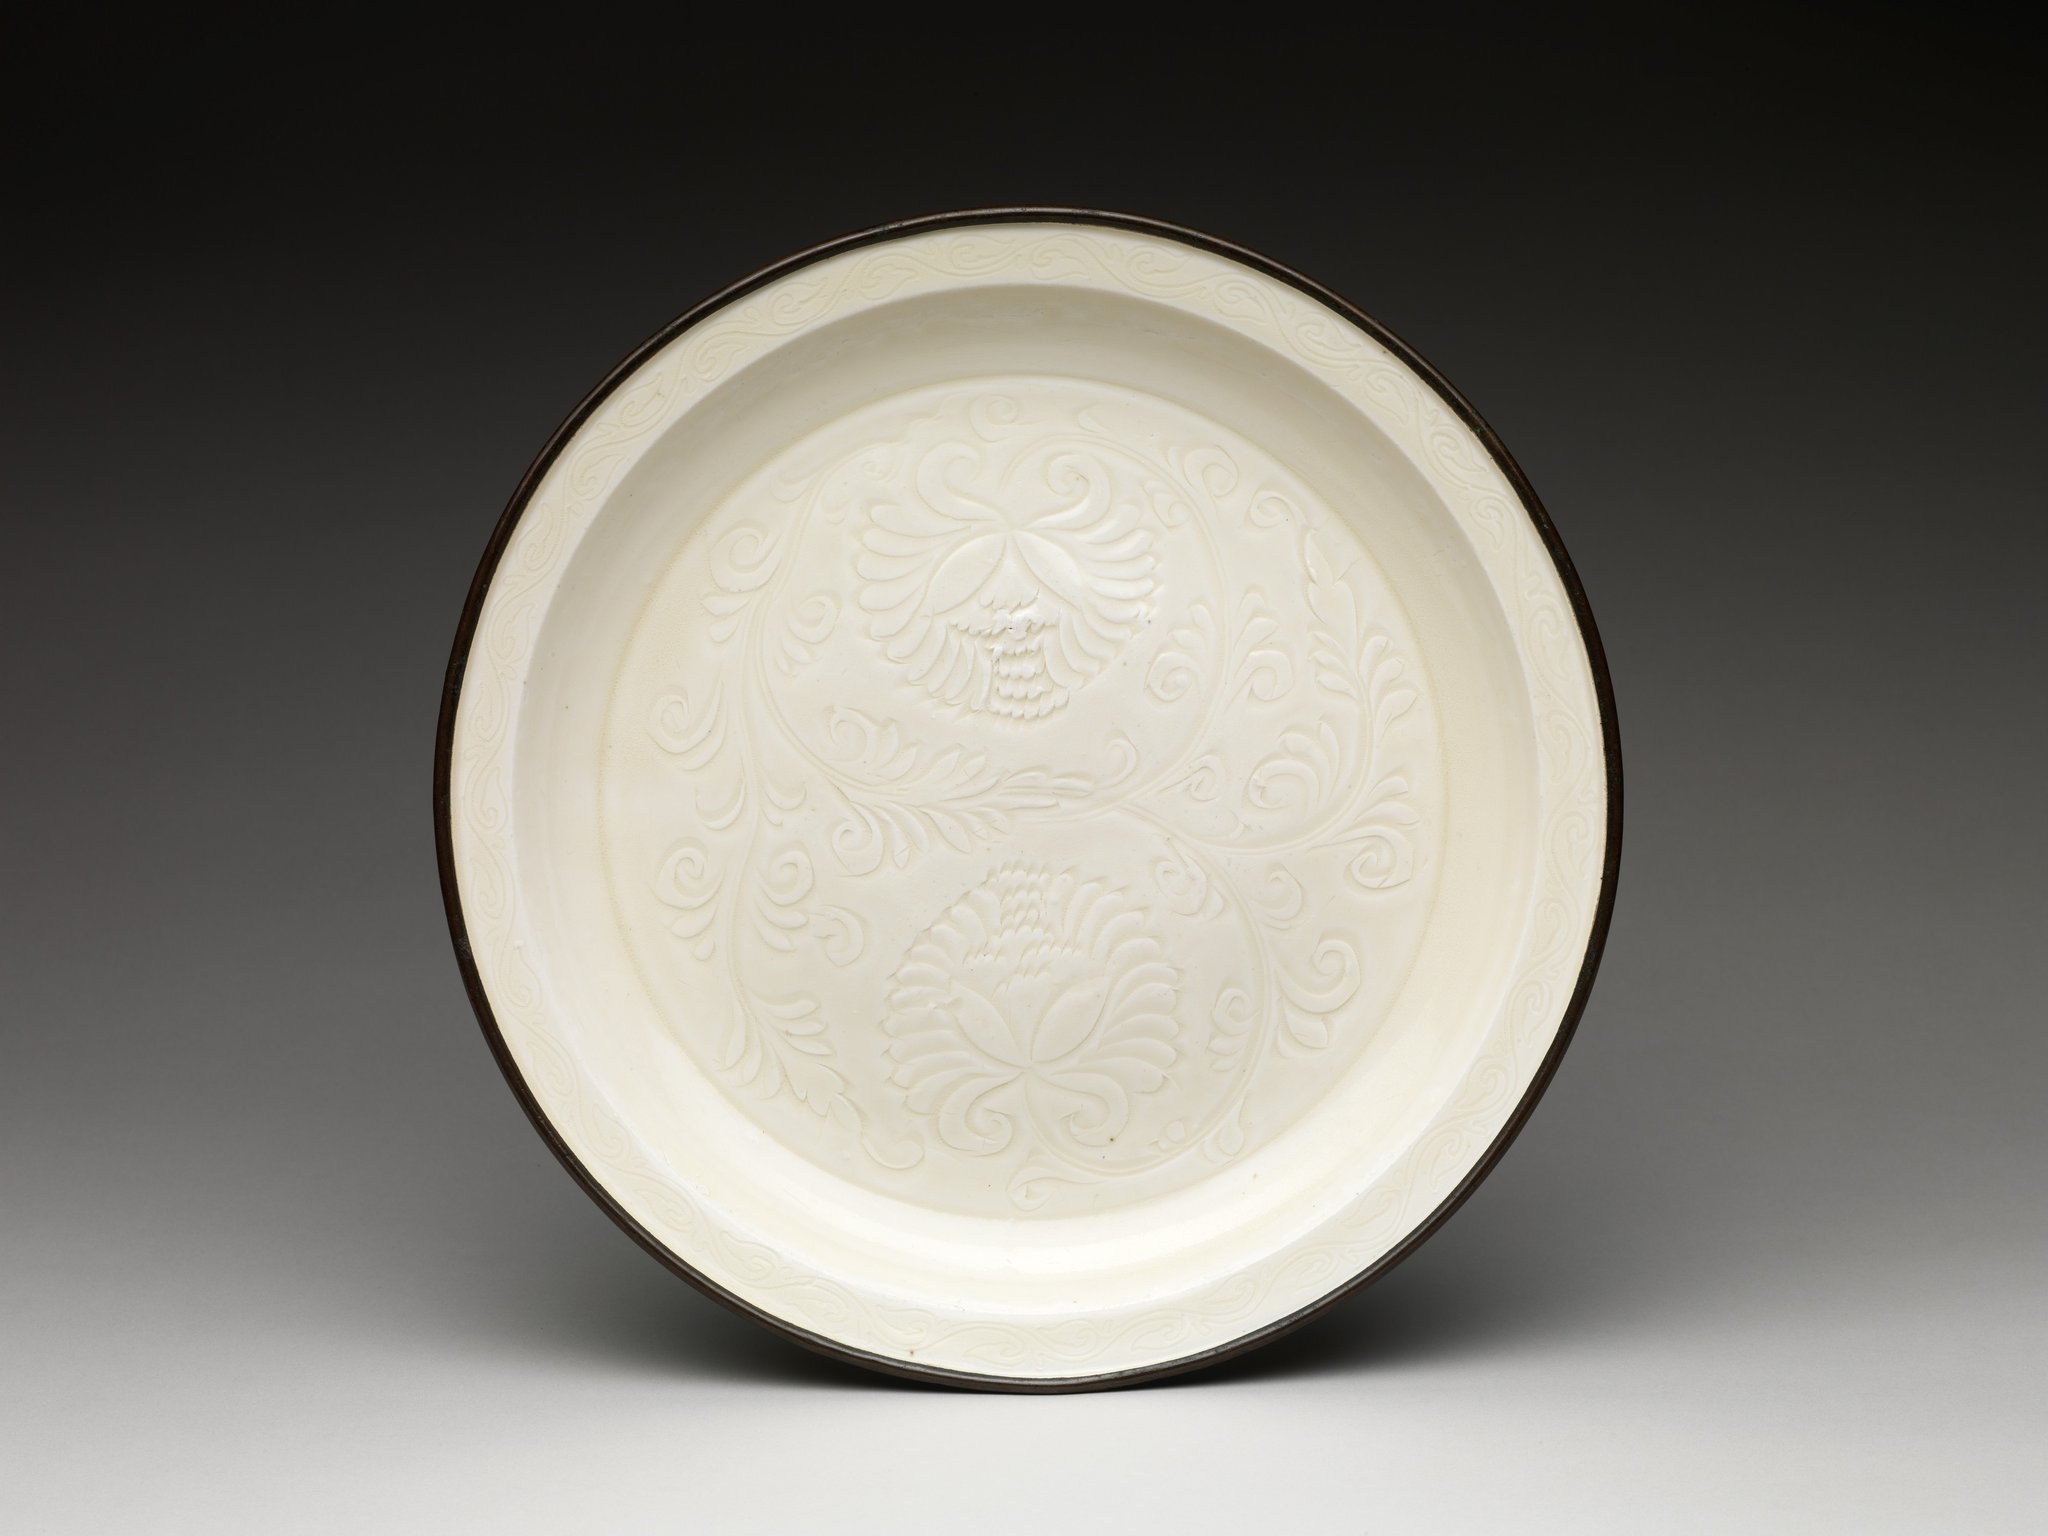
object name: plate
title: Plate with chrysanthemums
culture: chinese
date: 1101-1200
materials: copper, glaze, ivory, porcelain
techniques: incising